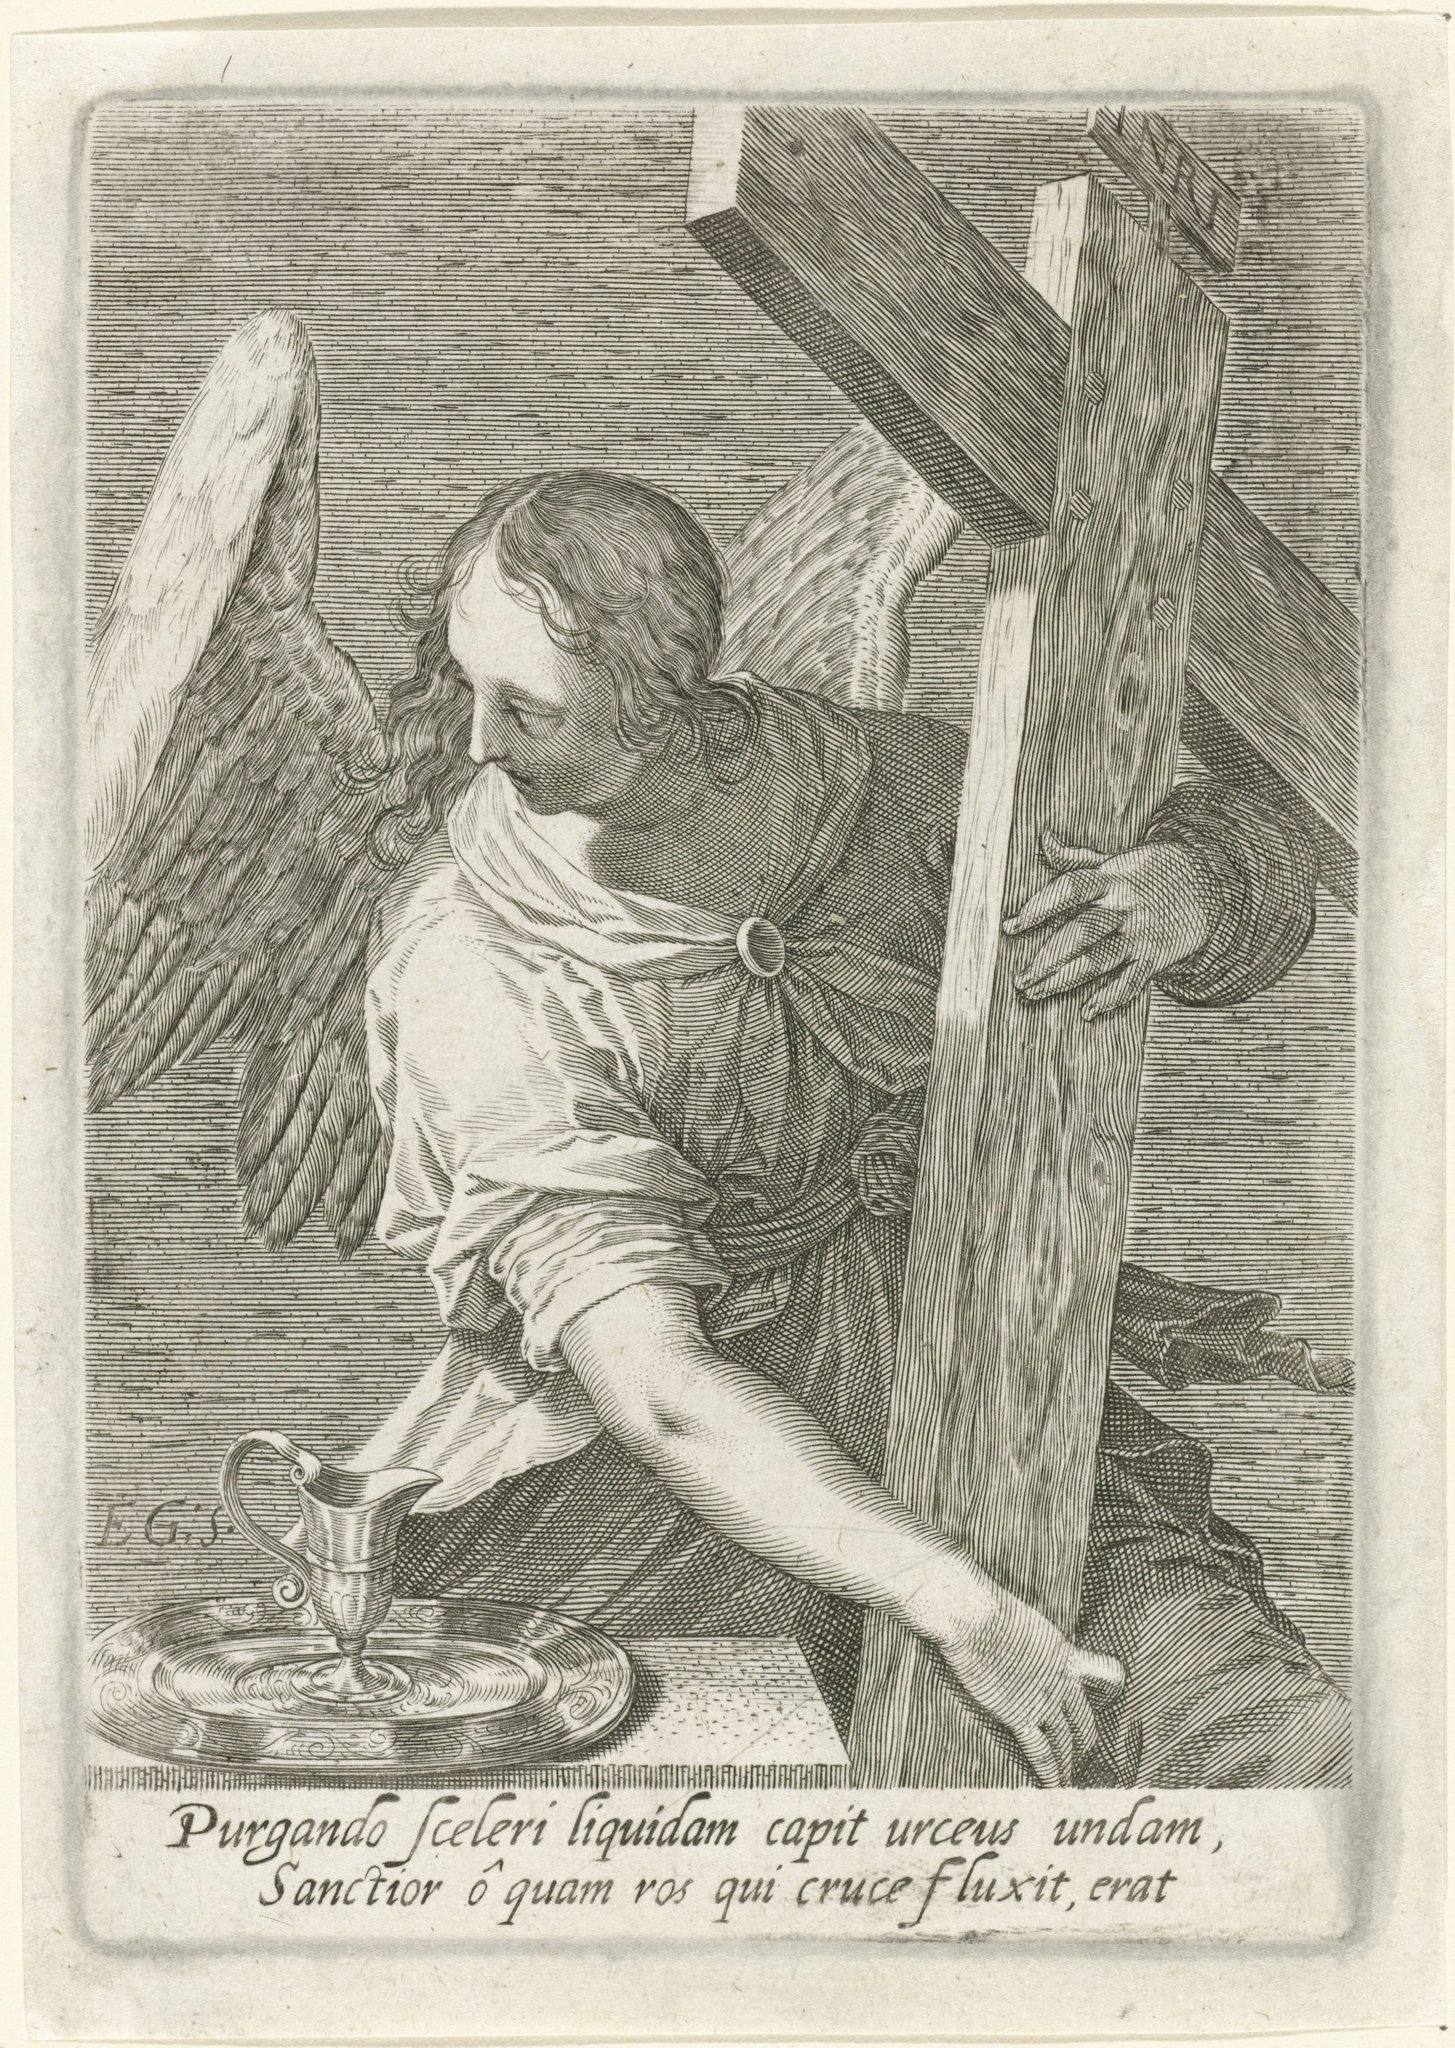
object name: print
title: Engel met het kruis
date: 1580-1629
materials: paper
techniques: engraving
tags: single instruments of the passion (with name), virtues (holding instruments of the passion) ~ hierarchy of angels, cross ~ instruments of the passion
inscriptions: collector's mark: Lugt 2228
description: Deze prent heeft tot 1966 deel uitgemaakt van een prentalbum met op de rug de titel: Print Boeck van Justus Sadeler. Bij aankoop in 1966 bevatte het album 32 prenten. 18 bladen met prenten zijn uit het album verwijderd en opgenomen in de collectie van het Rijksprentenkabinet. Zie voor dit album het gerelateerd object.